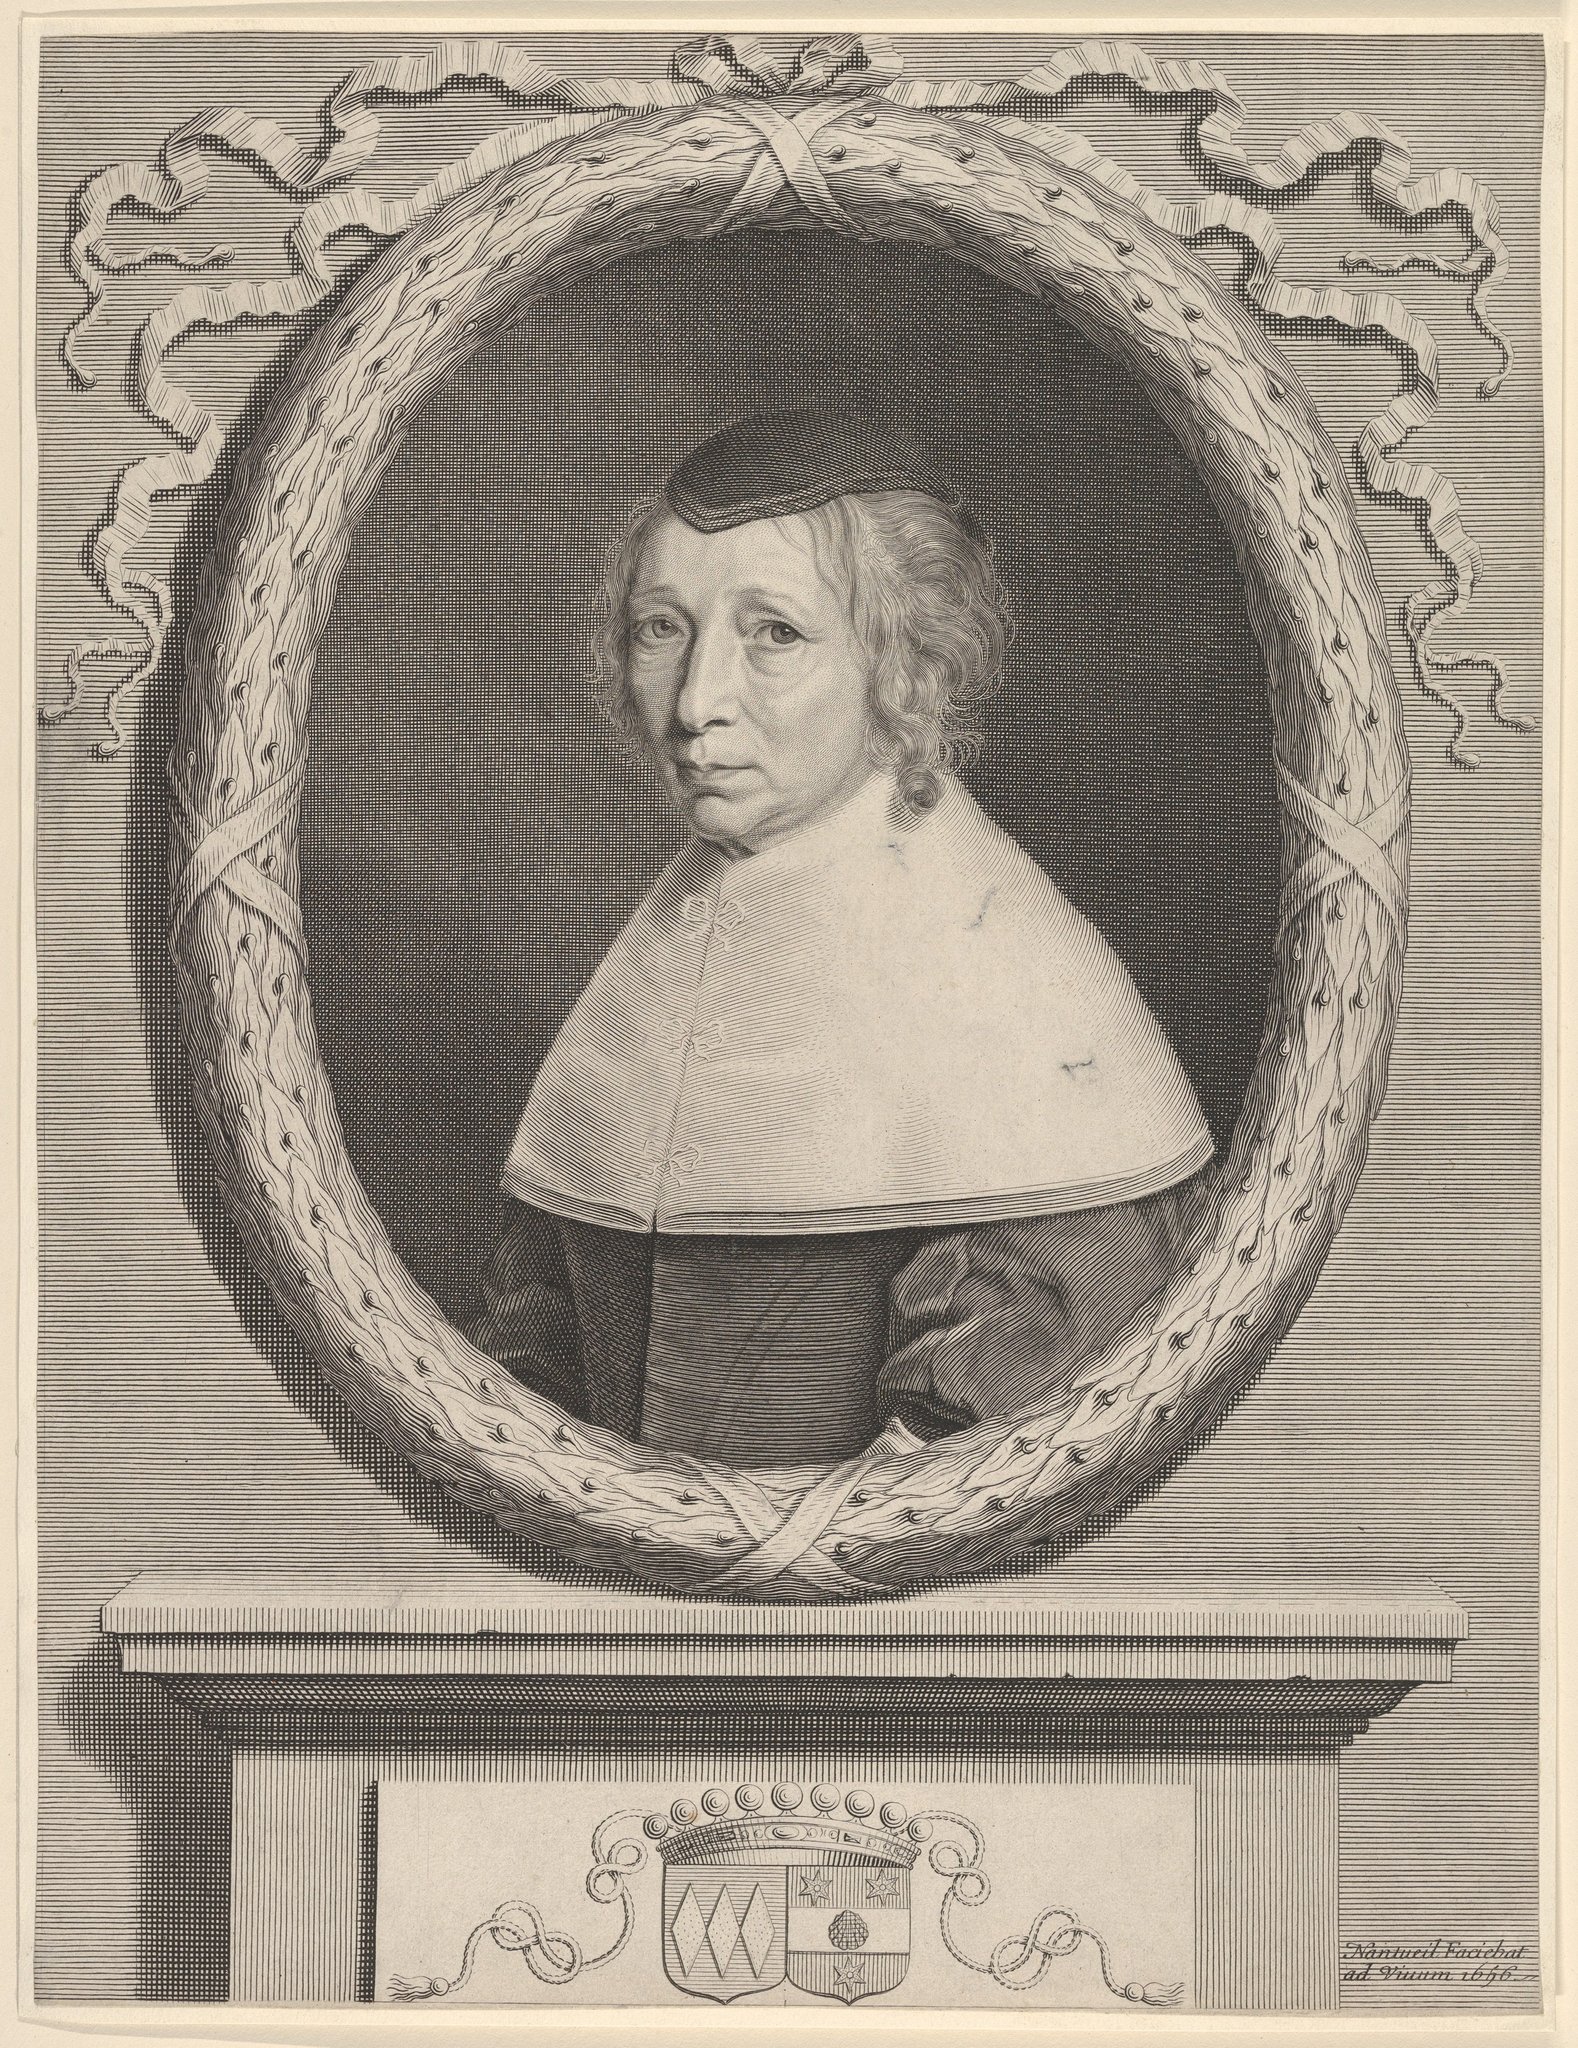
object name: print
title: Madame Bouthillier (Marie de Bragelogne)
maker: robert nanteuil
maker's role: artist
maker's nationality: french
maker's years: 1623-1678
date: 1656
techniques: engraving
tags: portraits,women,coat of arms